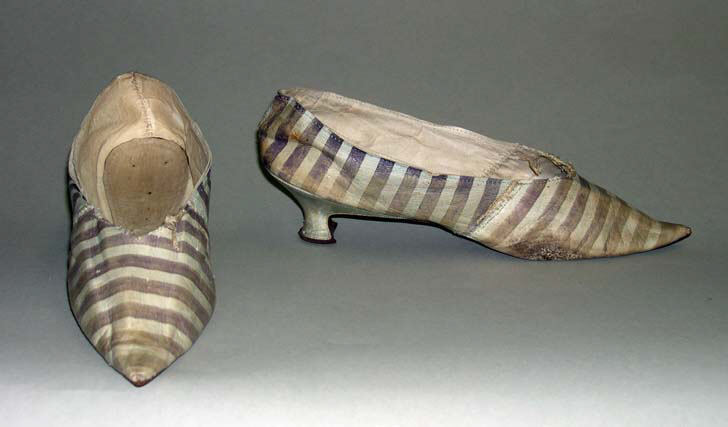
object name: shoe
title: Shoes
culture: european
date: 1780-1799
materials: leather